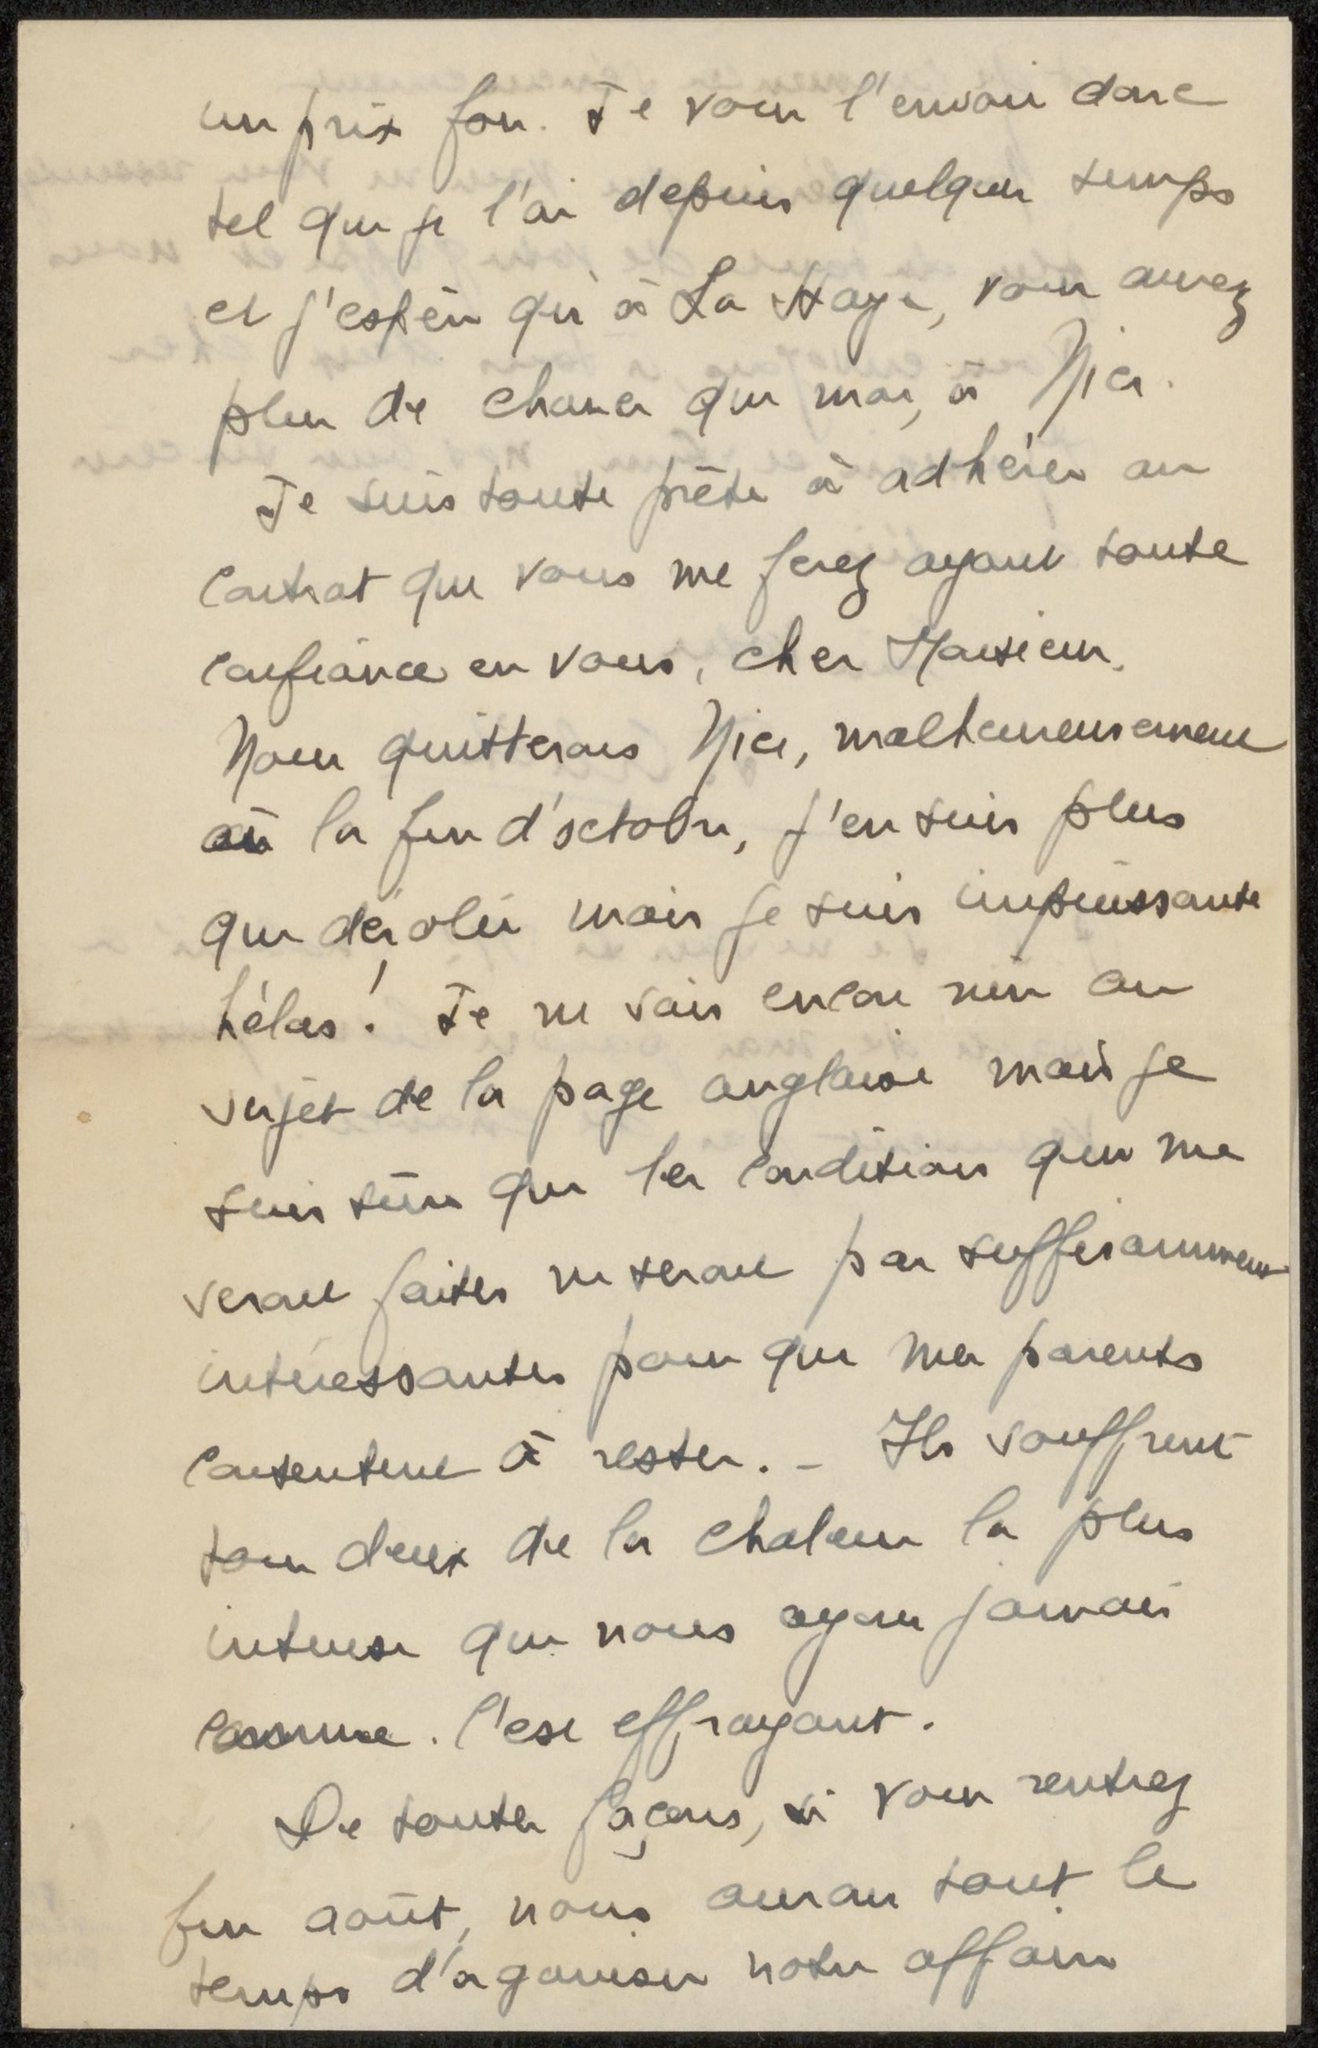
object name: letter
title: Brief aan Philip Zilcken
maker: jeanne erlich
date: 1923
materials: ink, paper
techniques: pen, printing, writing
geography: nice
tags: painter, draughtsman, philip zilcken, literature ~ arts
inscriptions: collector's mark: ‘RPK’